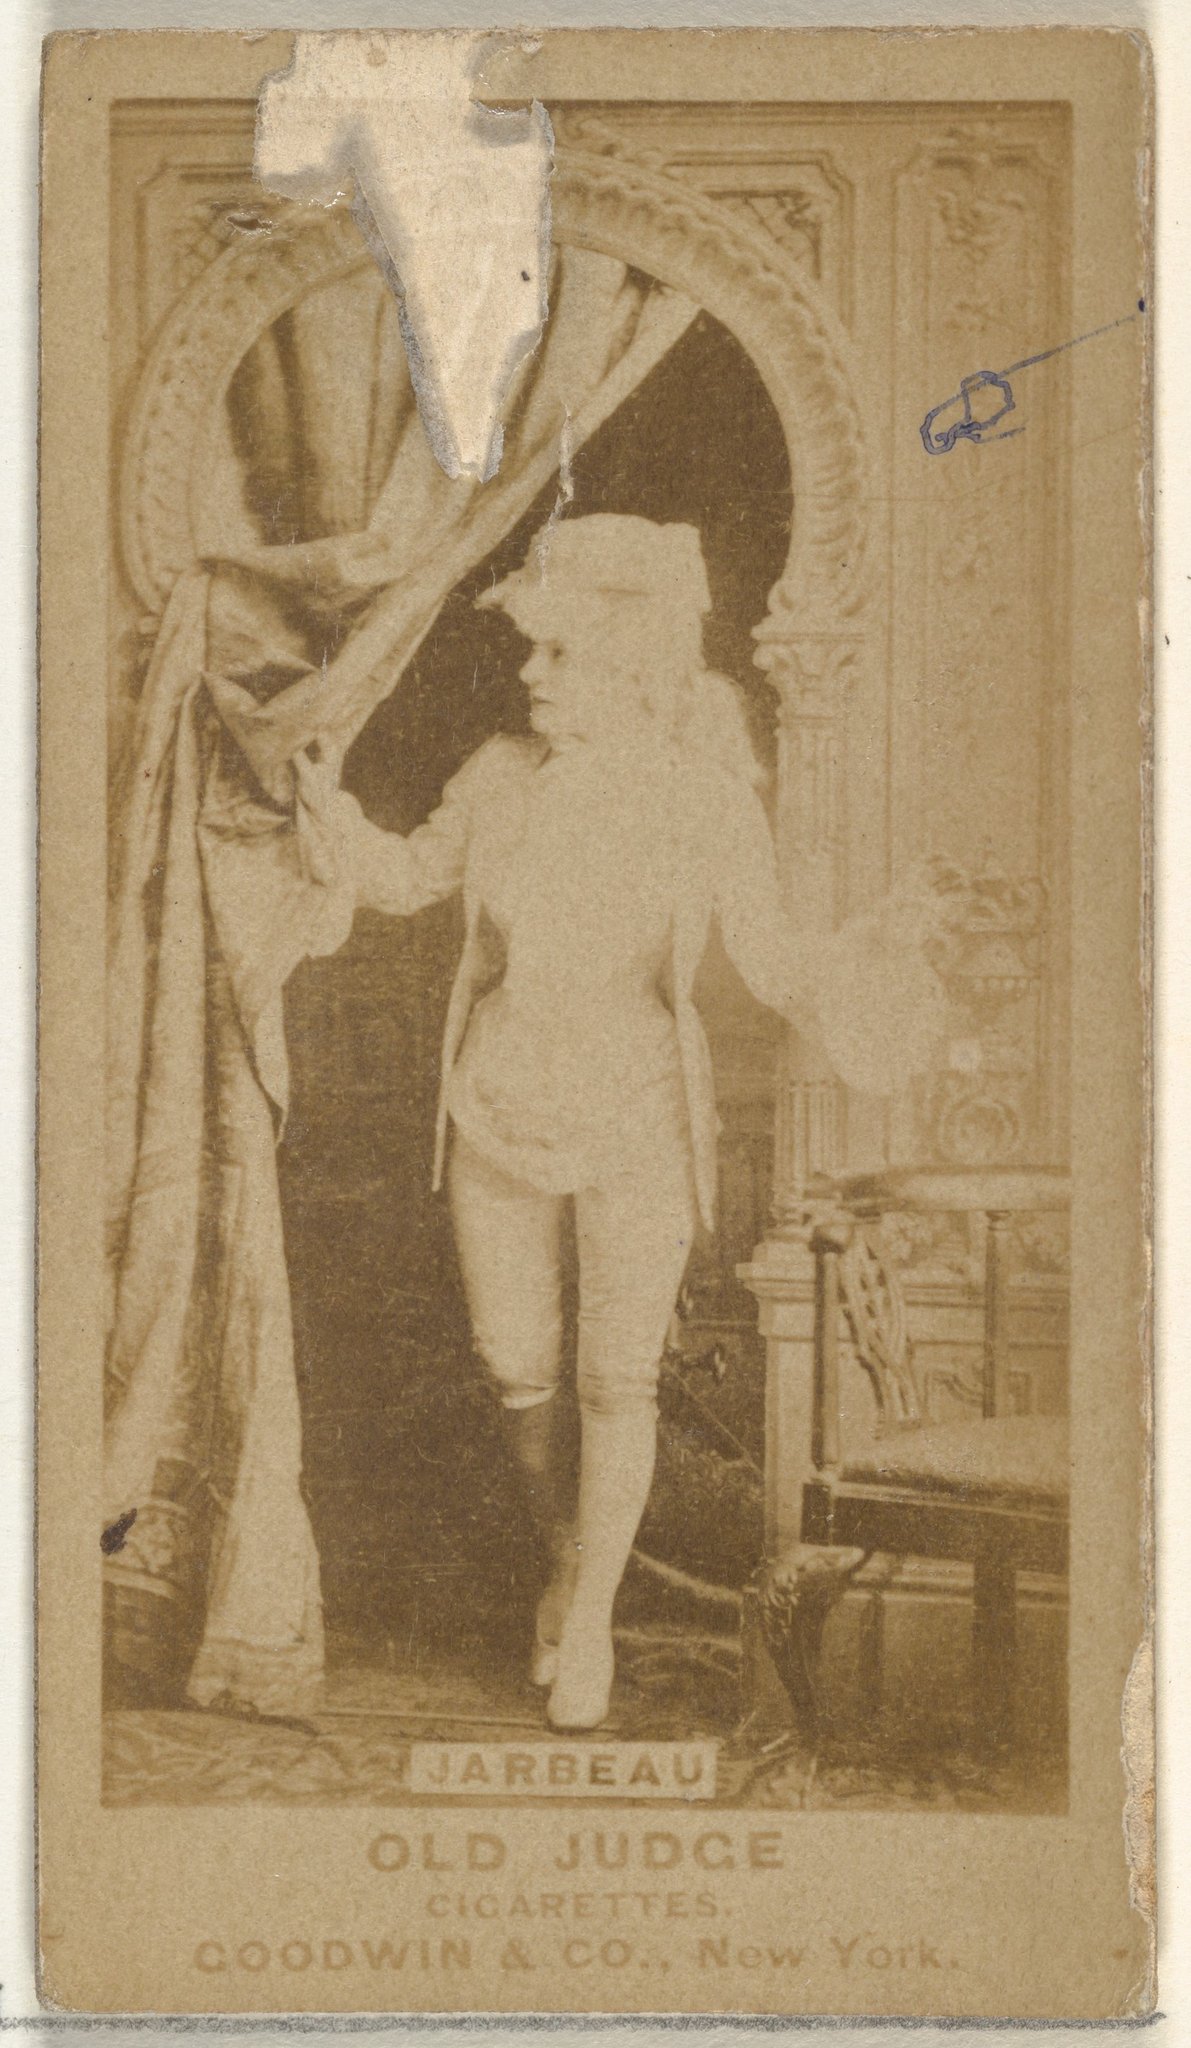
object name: photograph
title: Jarbeau, from the Actors and Actresses series (N171) for Old Judge Cigarettes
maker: goodwin & company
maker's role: publisher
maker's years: 1850-1950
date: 1886-1890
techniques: albumen silver print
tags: portraits,women,actresses